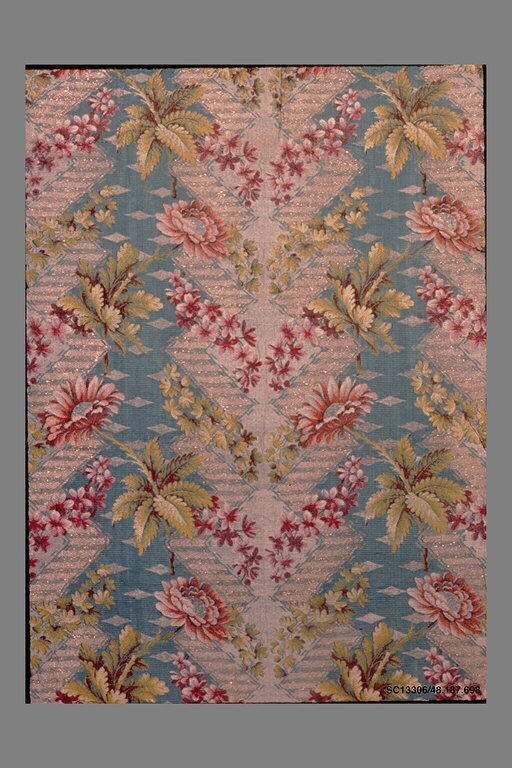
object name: piece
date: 1730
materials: metal thread, silk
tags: flowers,leaves